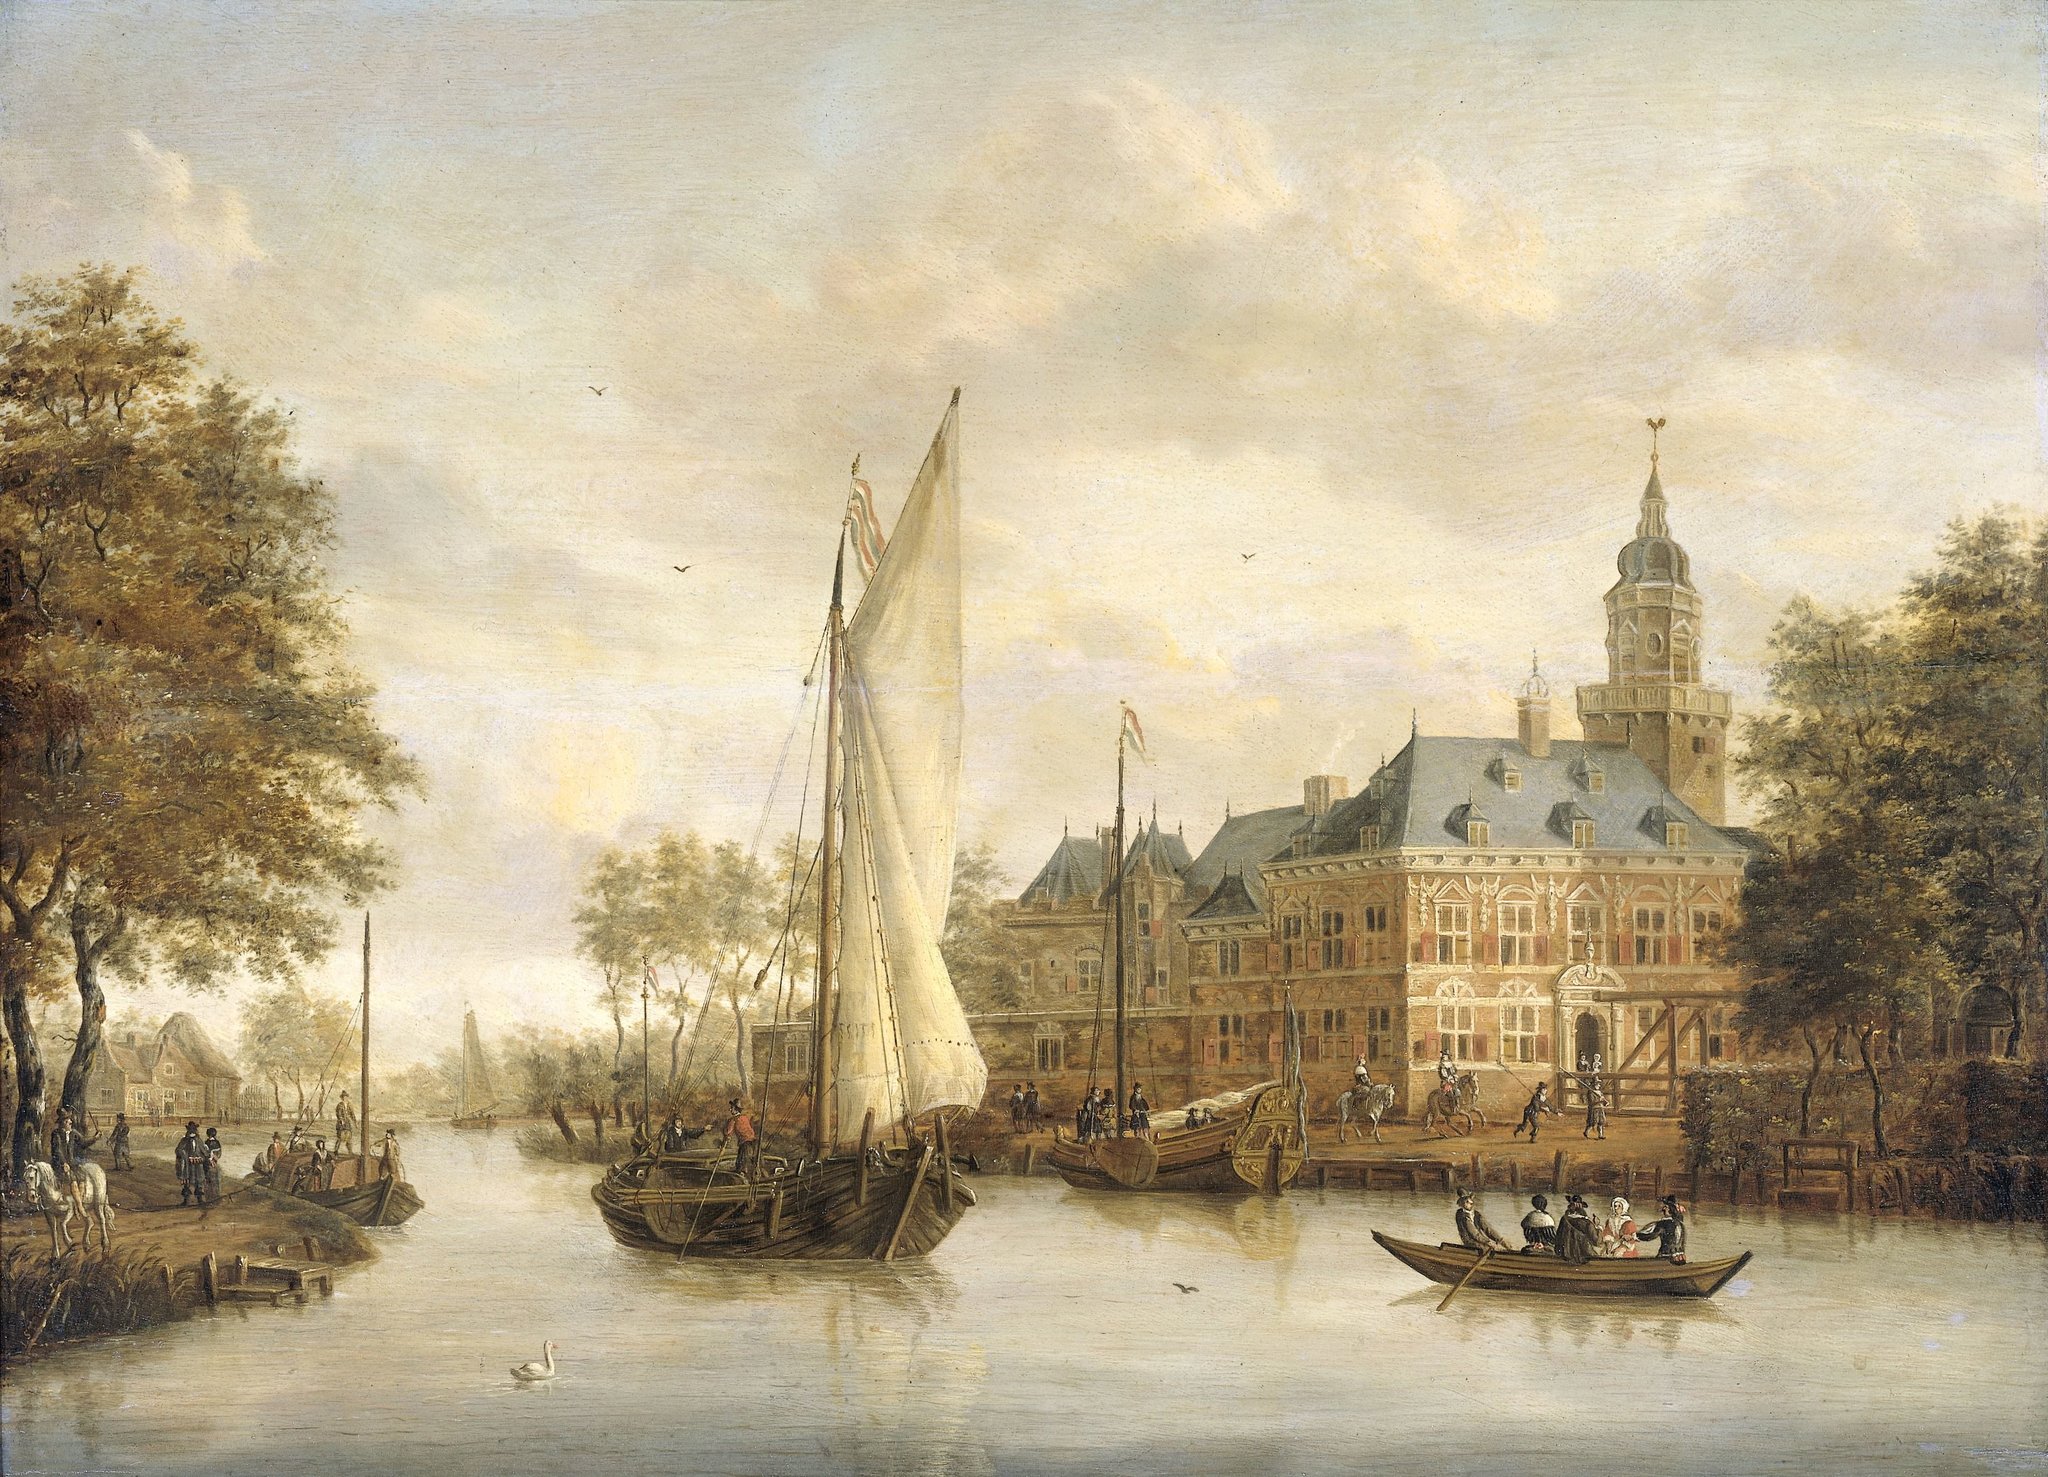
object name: painting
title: Nijenrode Castle on the Vecht near Breukelen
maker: jacobus storck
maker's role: draughtsman, painter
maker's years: 1641-1712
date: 1660-1686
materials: oil, panel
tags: sailing-ship, sailing-boat, castle, river, vecht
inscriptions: signature: ‘J. Storck’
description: Het kasteel Nijenrode aan de Vecht bij Breukelen. Een jacht ligt bij het kasteel aangemeerd. Op het water van de Vecht een schuit en een roeiboot, links een trekschuit.